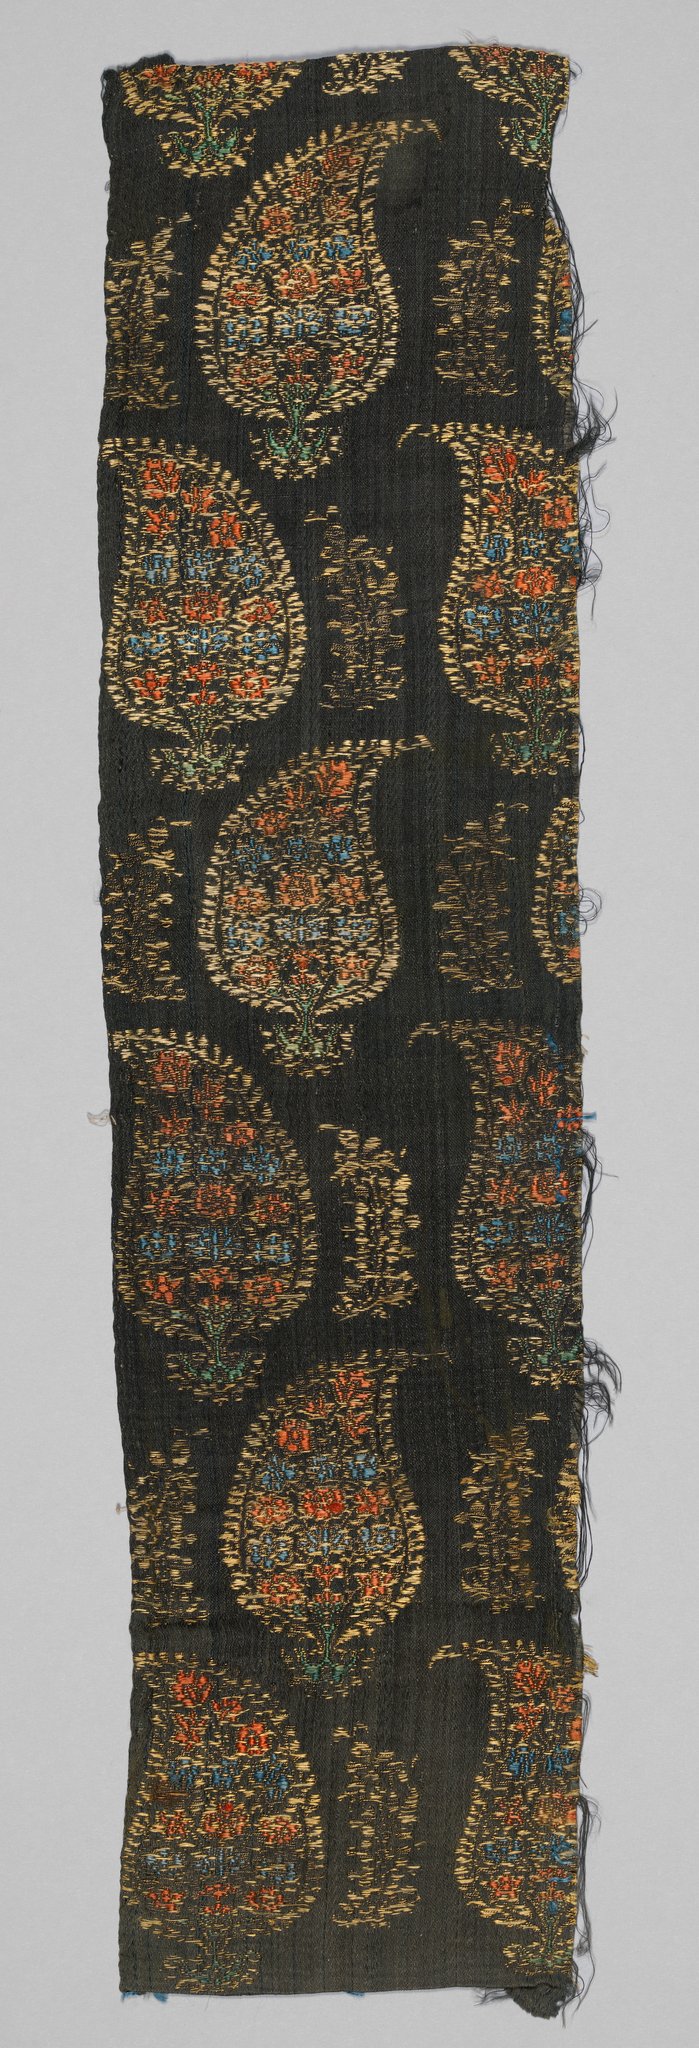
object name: textile fragment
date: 1601-1900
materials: metal thread, silk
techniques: brocade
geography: india